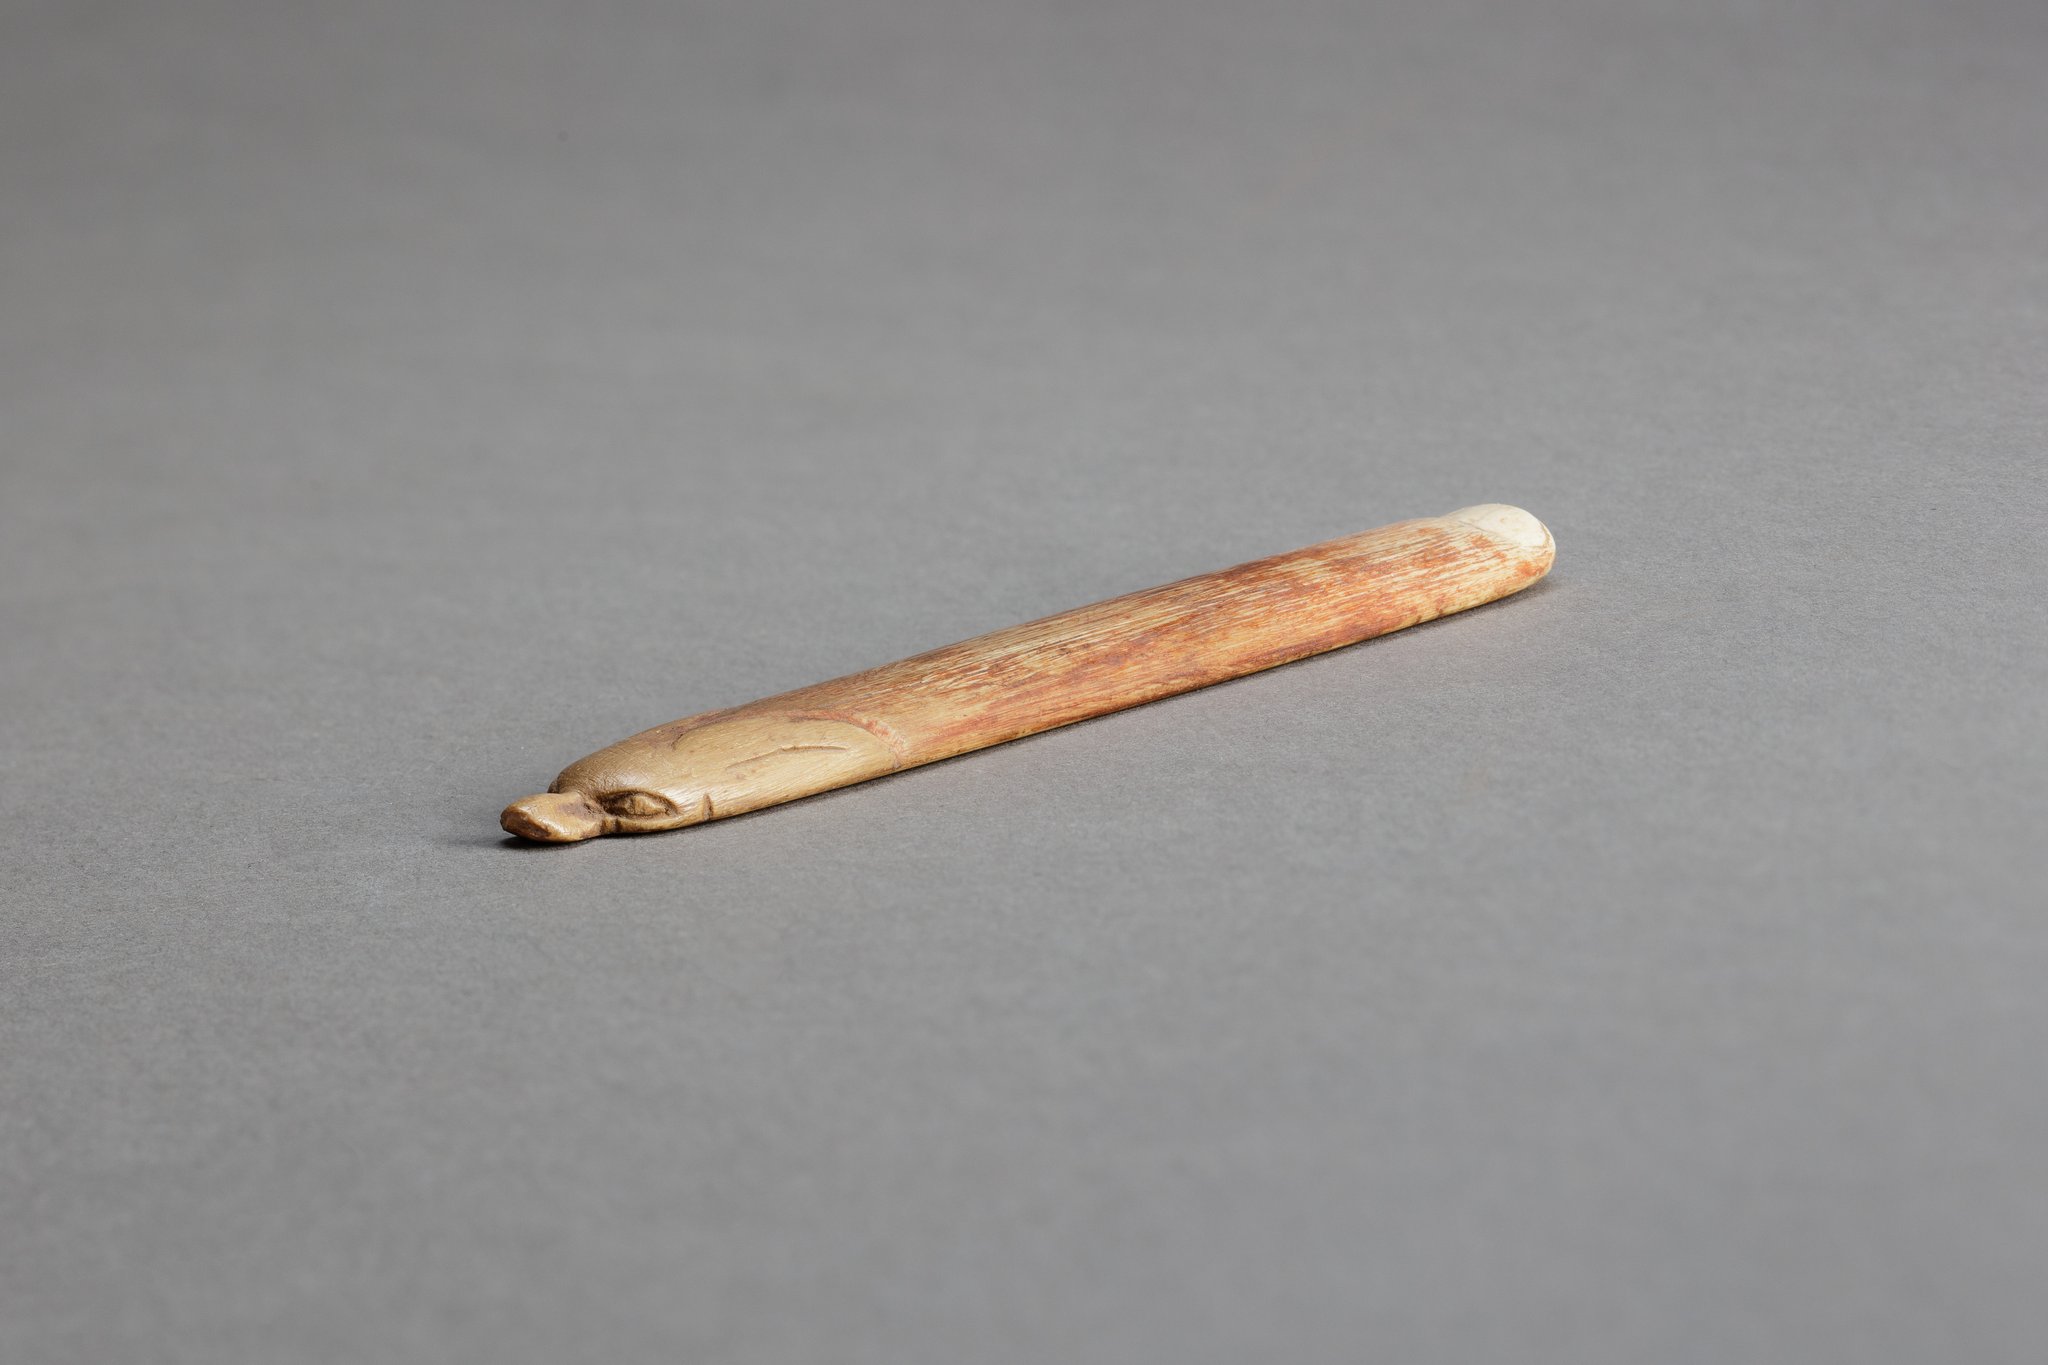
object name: throw stick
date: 1400-1295 BCE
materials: ivory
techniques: tinting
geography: upper egypt, thebes